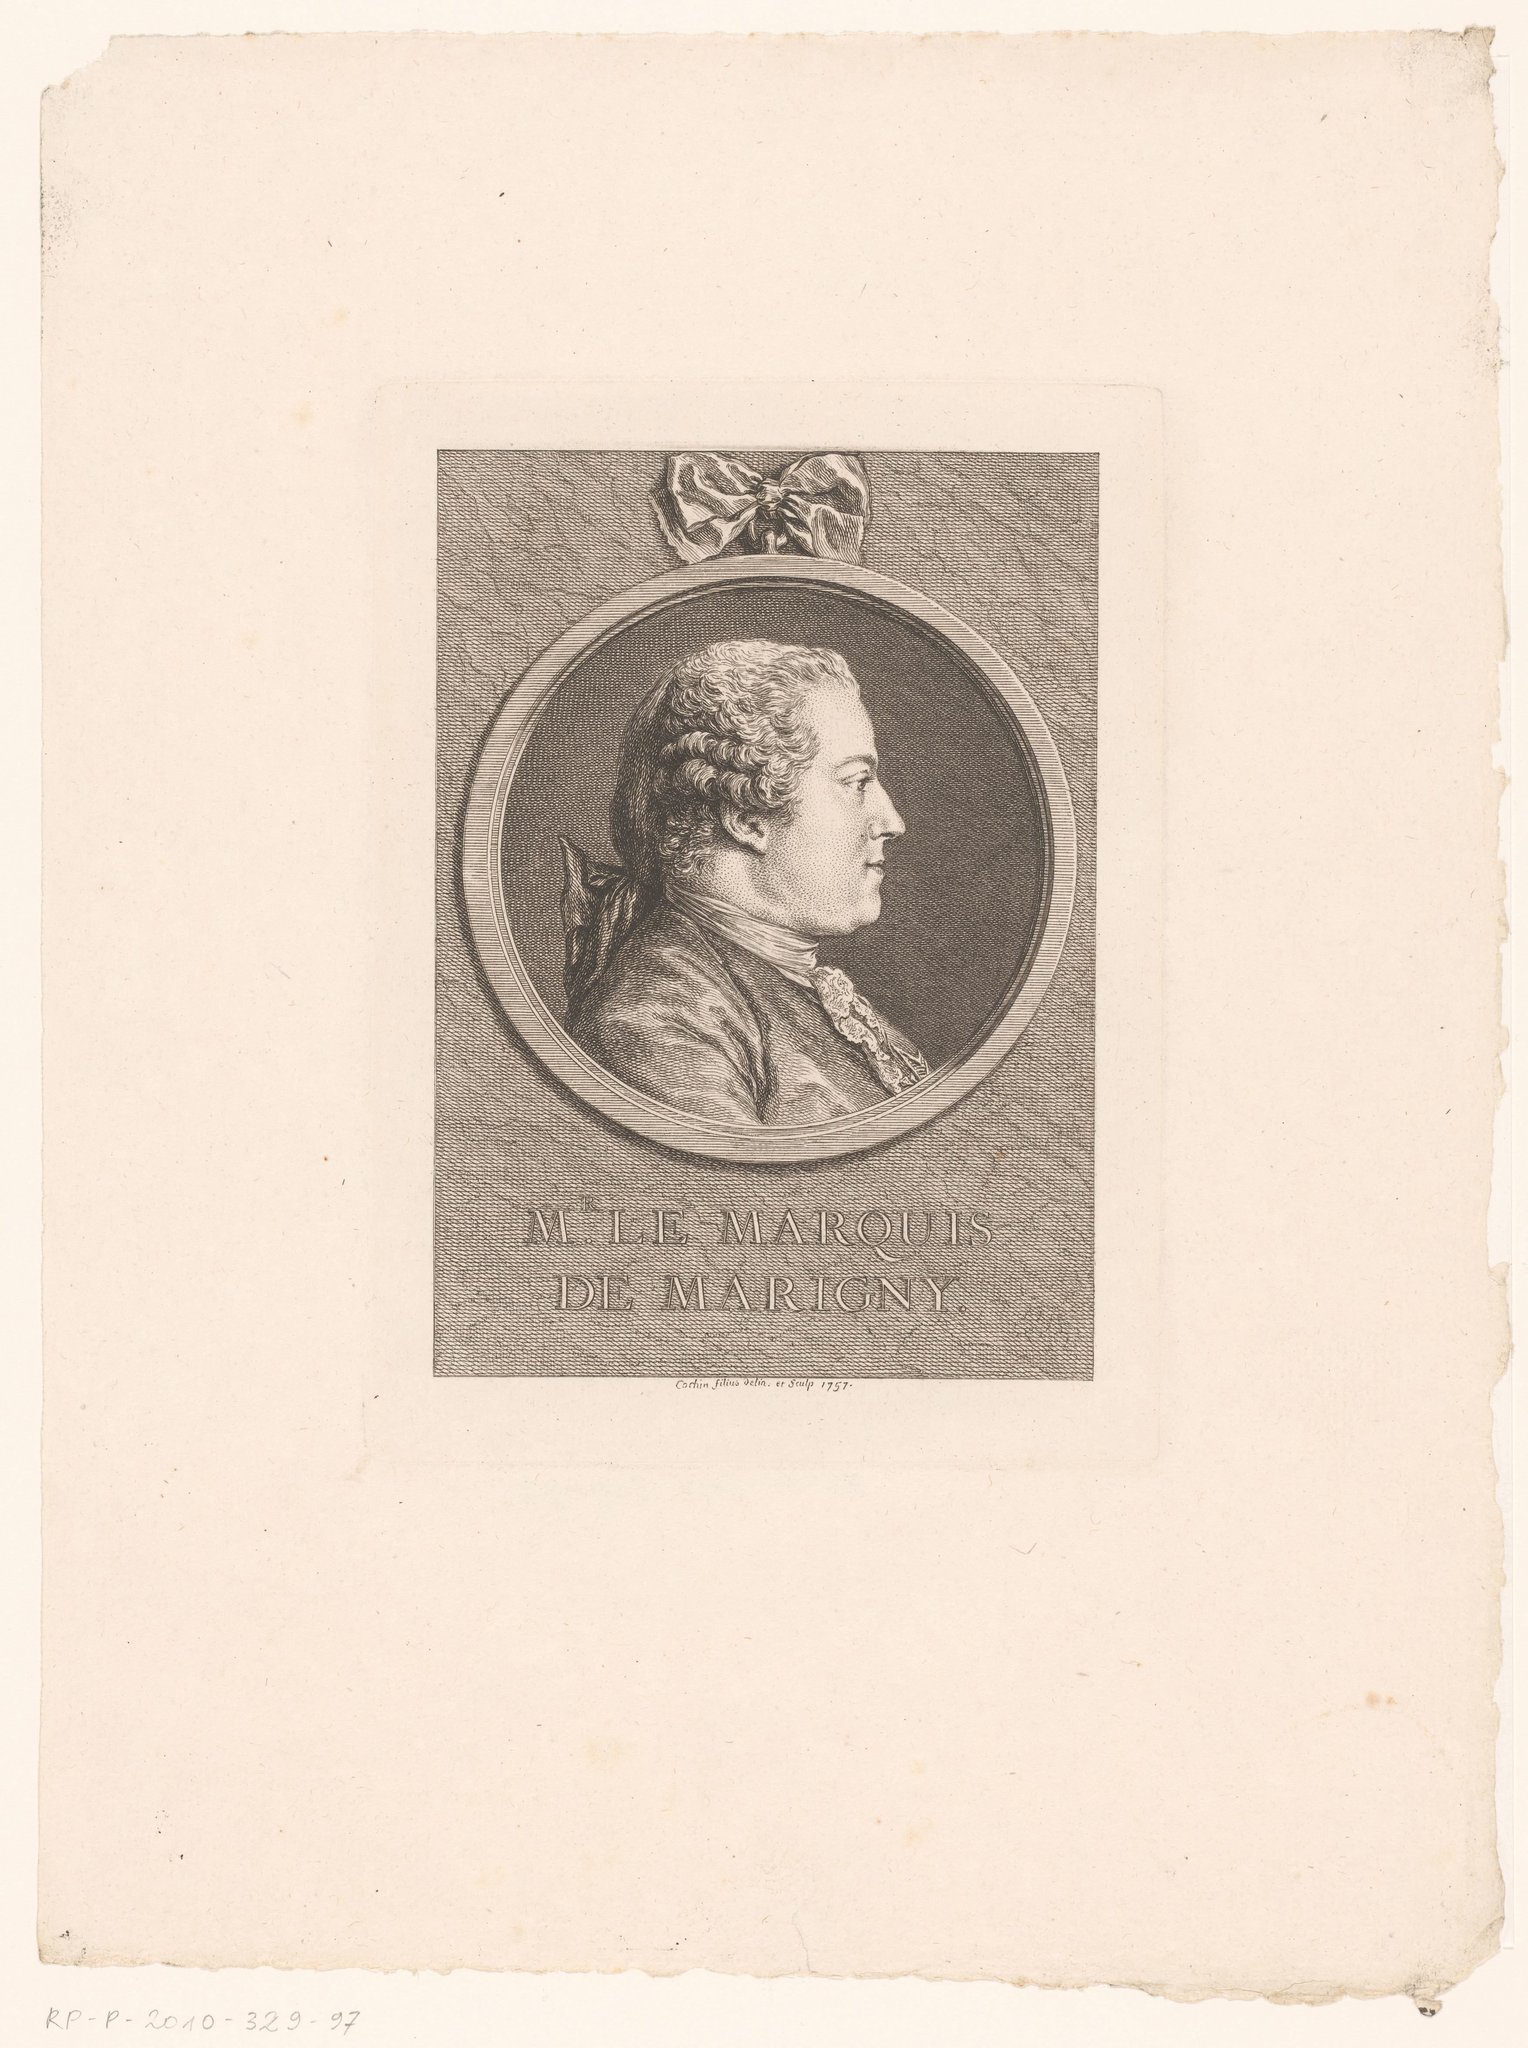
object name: print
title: Mr. le marquis de Marigny.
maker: charles nicolas cochin (ii)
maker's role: draughtsman, print maker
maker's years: 1715-1790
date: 1757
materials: paper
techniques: engraving, etching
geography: france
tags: paris, abel françois poisson de vandières (marquis de marigny), ornament ~ medallion, historical persons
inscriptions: collector's mark: Lugt 2228